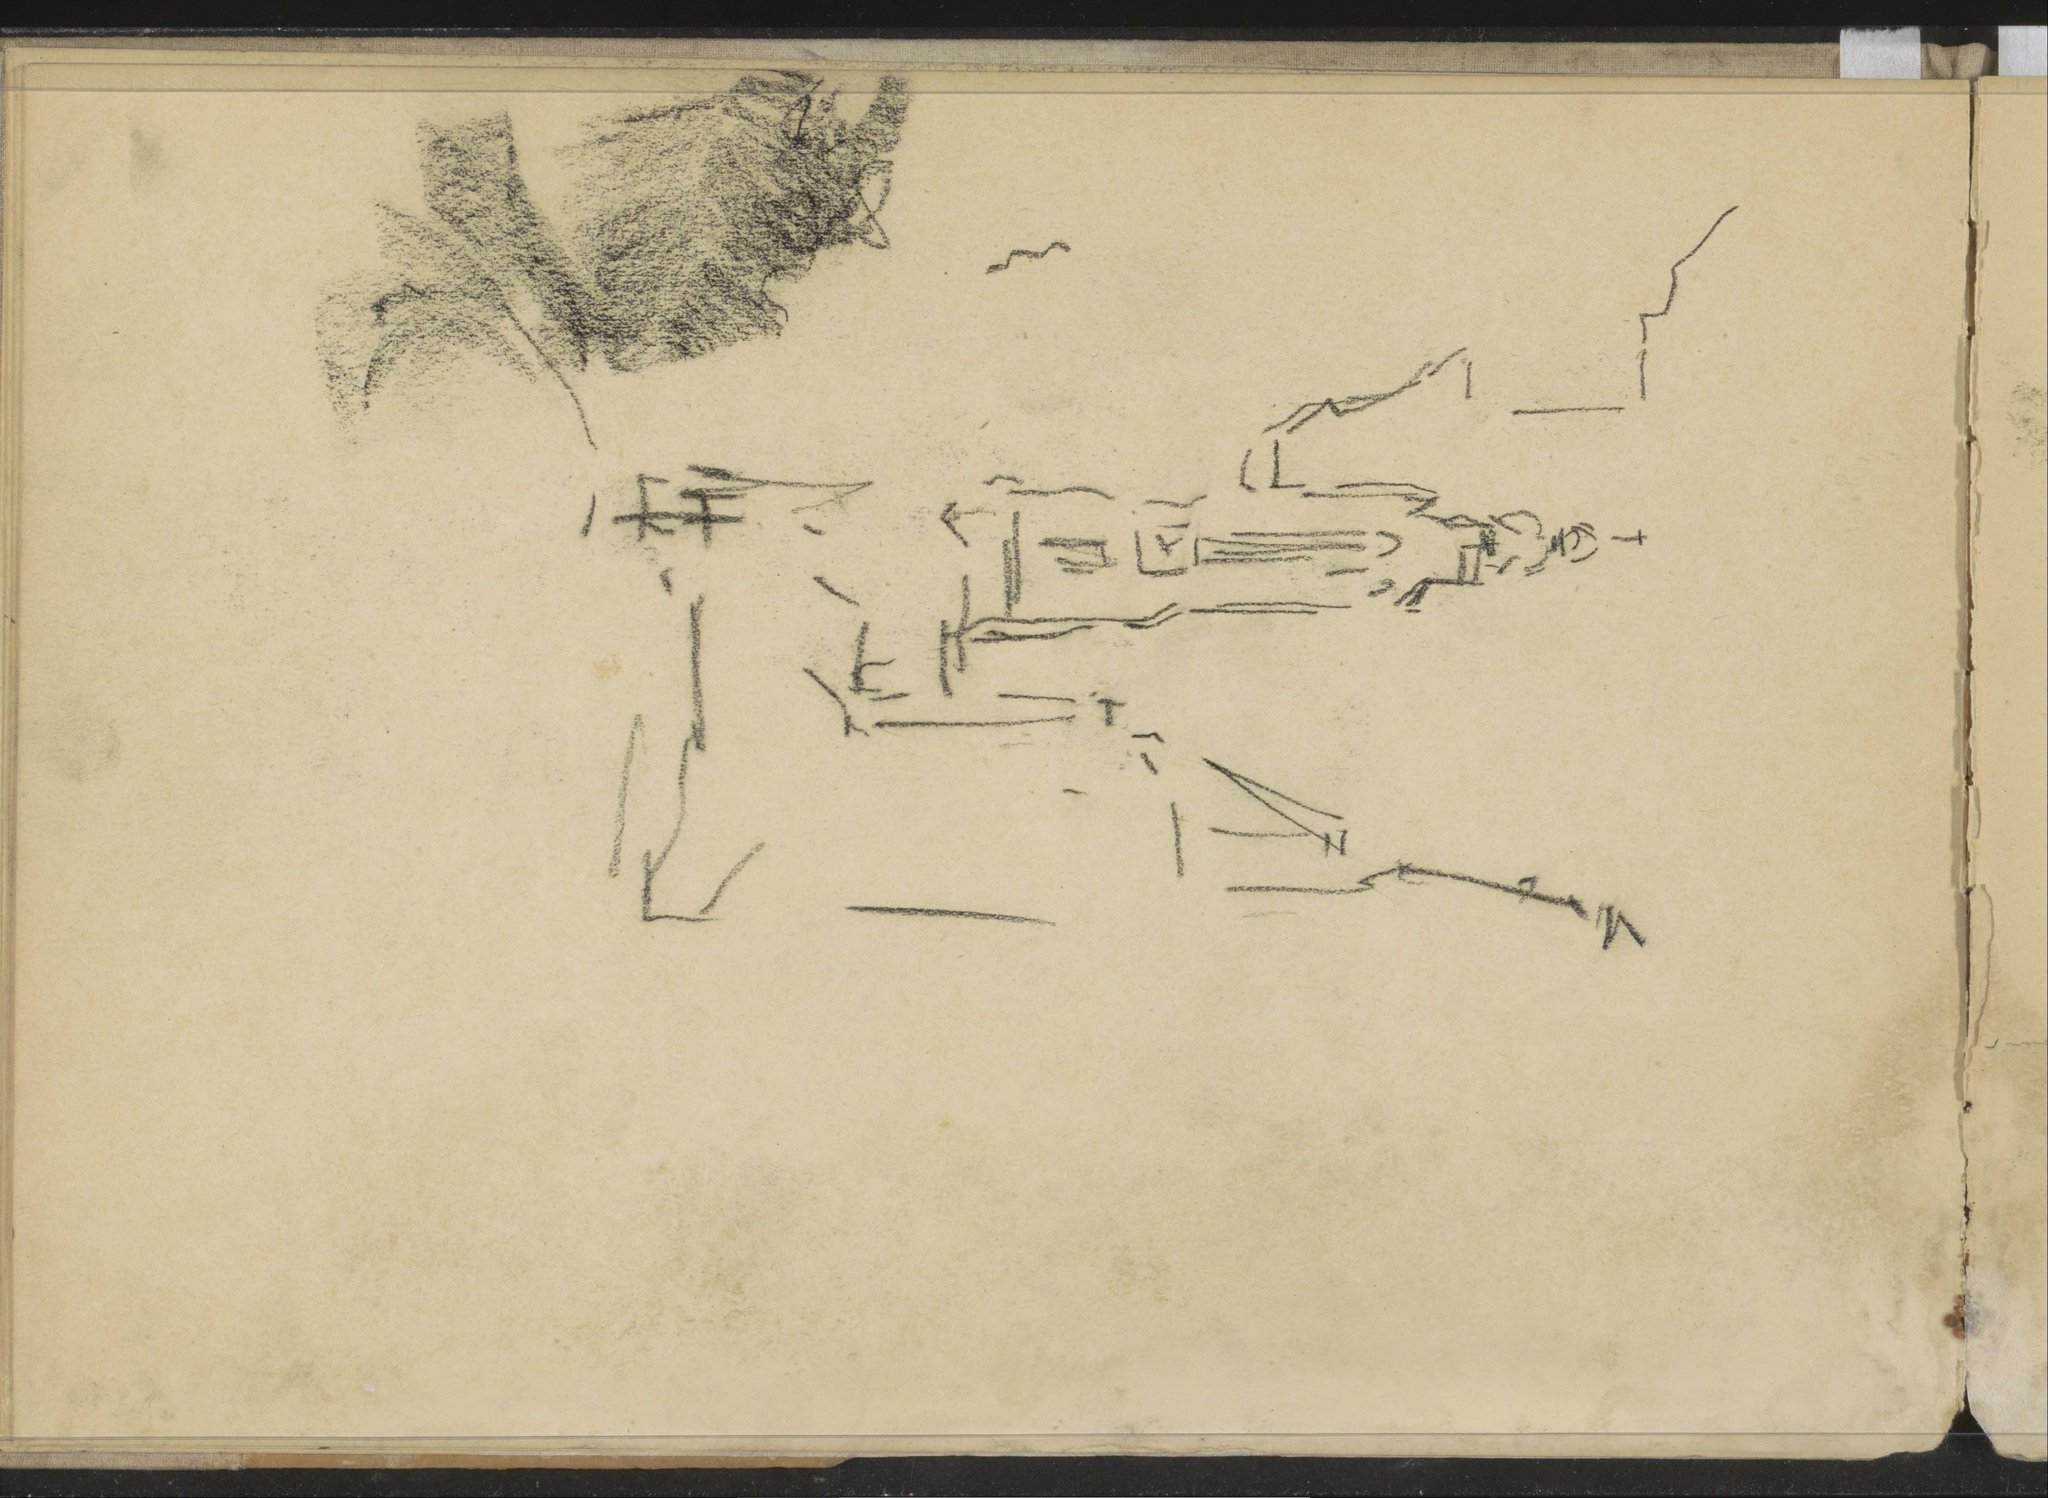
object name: sketchbook leaf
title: Straat met een kerktoren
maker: willem bastiaan tholen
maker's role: draughtsman, painter, print maker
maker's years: 1860-1931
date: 1885-1931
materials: chalk, paper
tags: church (exterior), street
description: Blad 6 verso uit een schetsboek met 28 bladen.